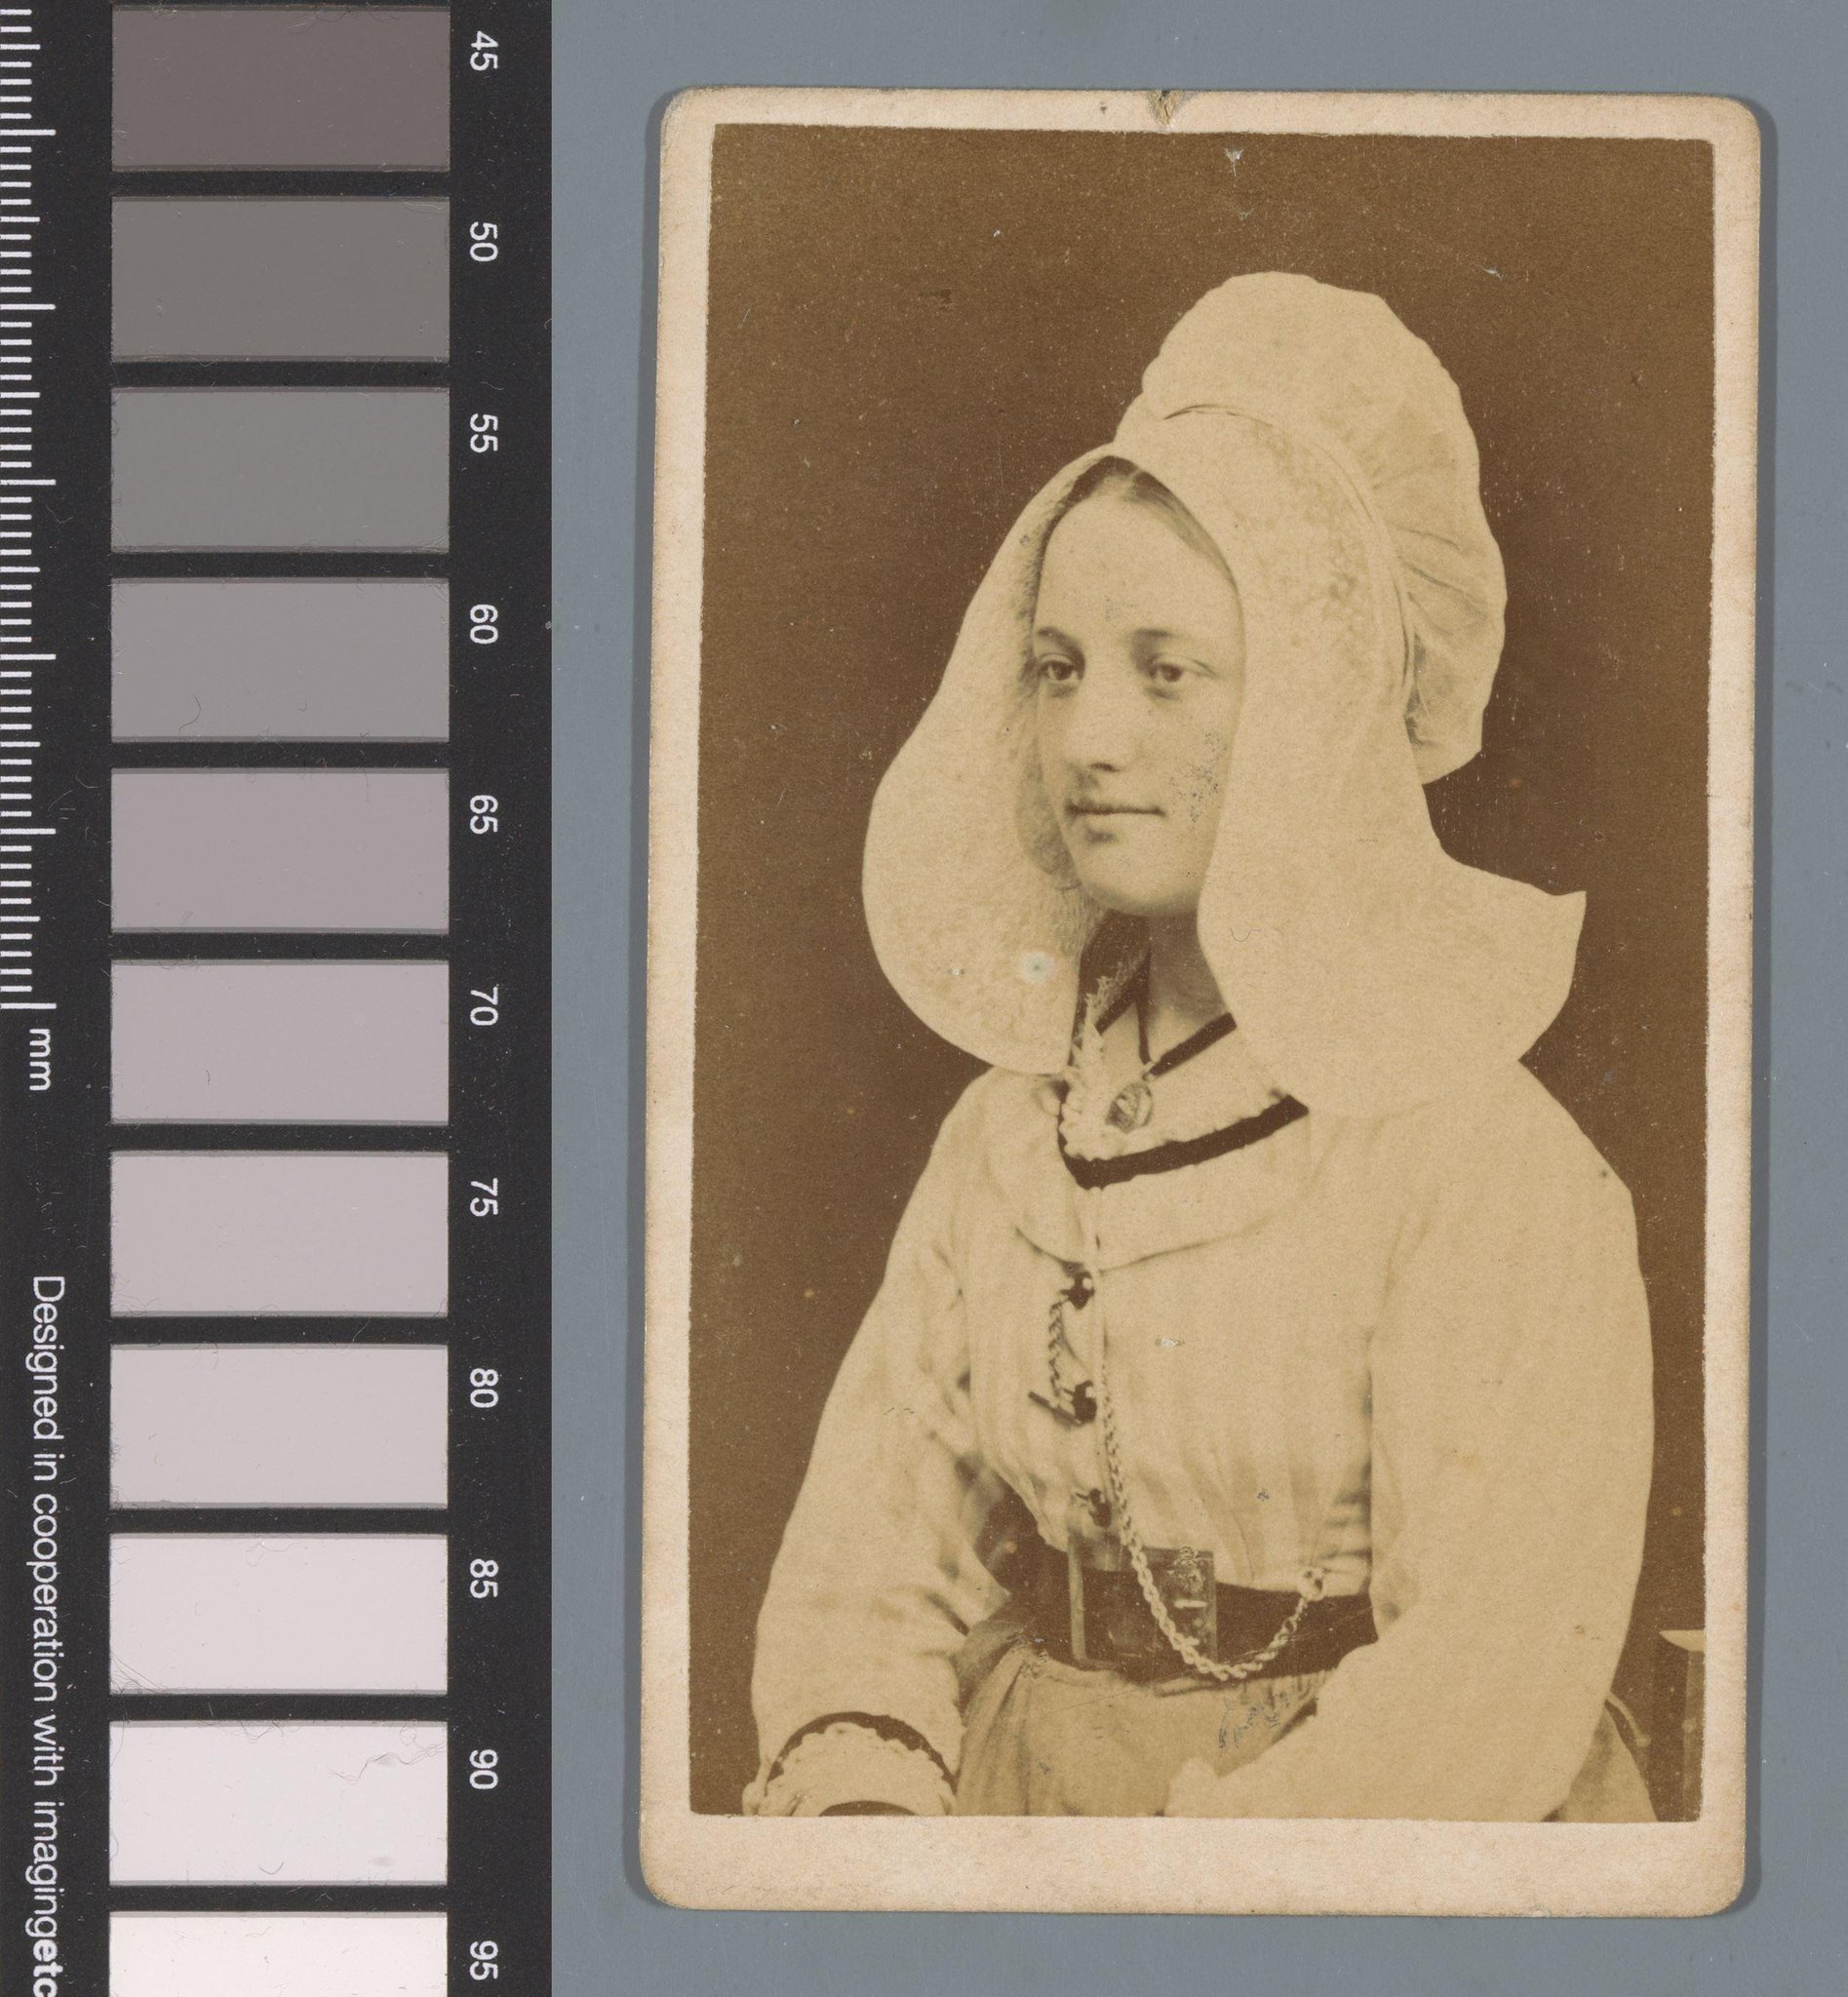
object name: photograph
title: Portret van een onbekende vrouw in vermoedelijk de klederdracht van Noord-Brabant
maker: Anonymous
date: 1870-1880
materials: cardboard, photographic support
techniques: albumen print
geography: netherlands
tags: folk costume, regional costume